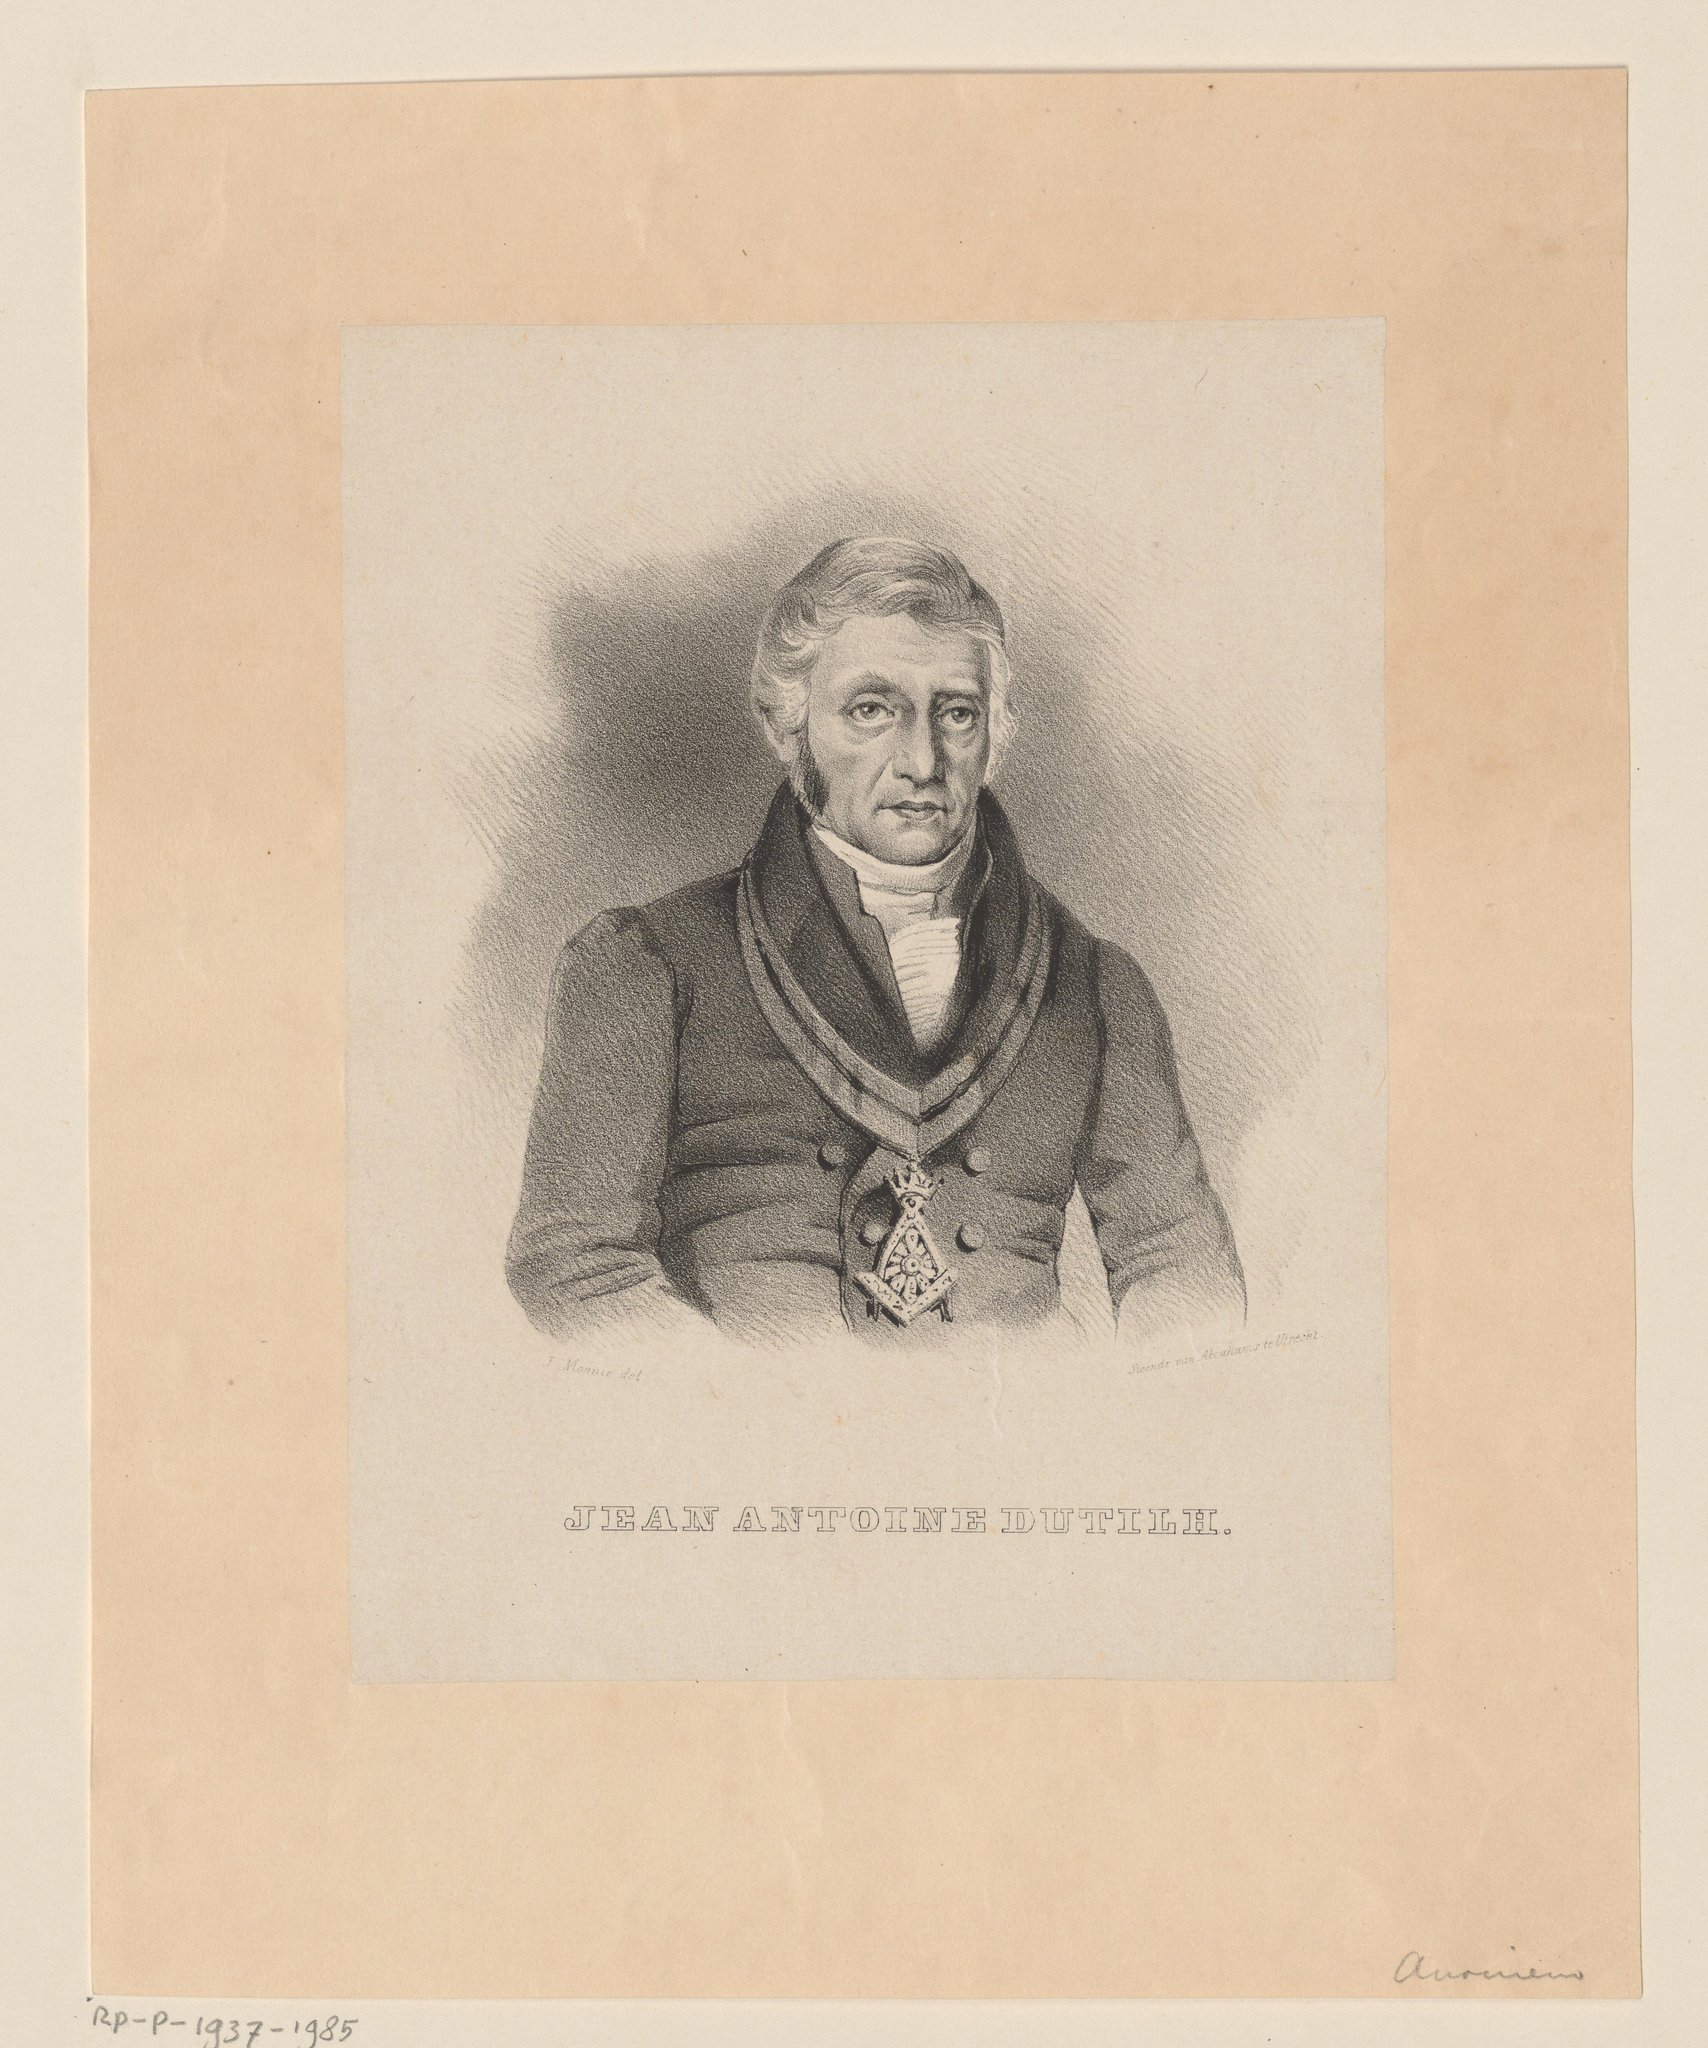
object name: print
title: Portret van Jean Antoine Dutilh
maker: j. monnie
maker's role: draughtsman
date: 1825-1849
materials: paper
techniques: lithograph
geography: utrecht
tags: rotterdam, gouda, ranks in the army, historical persons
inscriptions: collector's mark: Lugt 2760, collector's mark: Lugt 2228